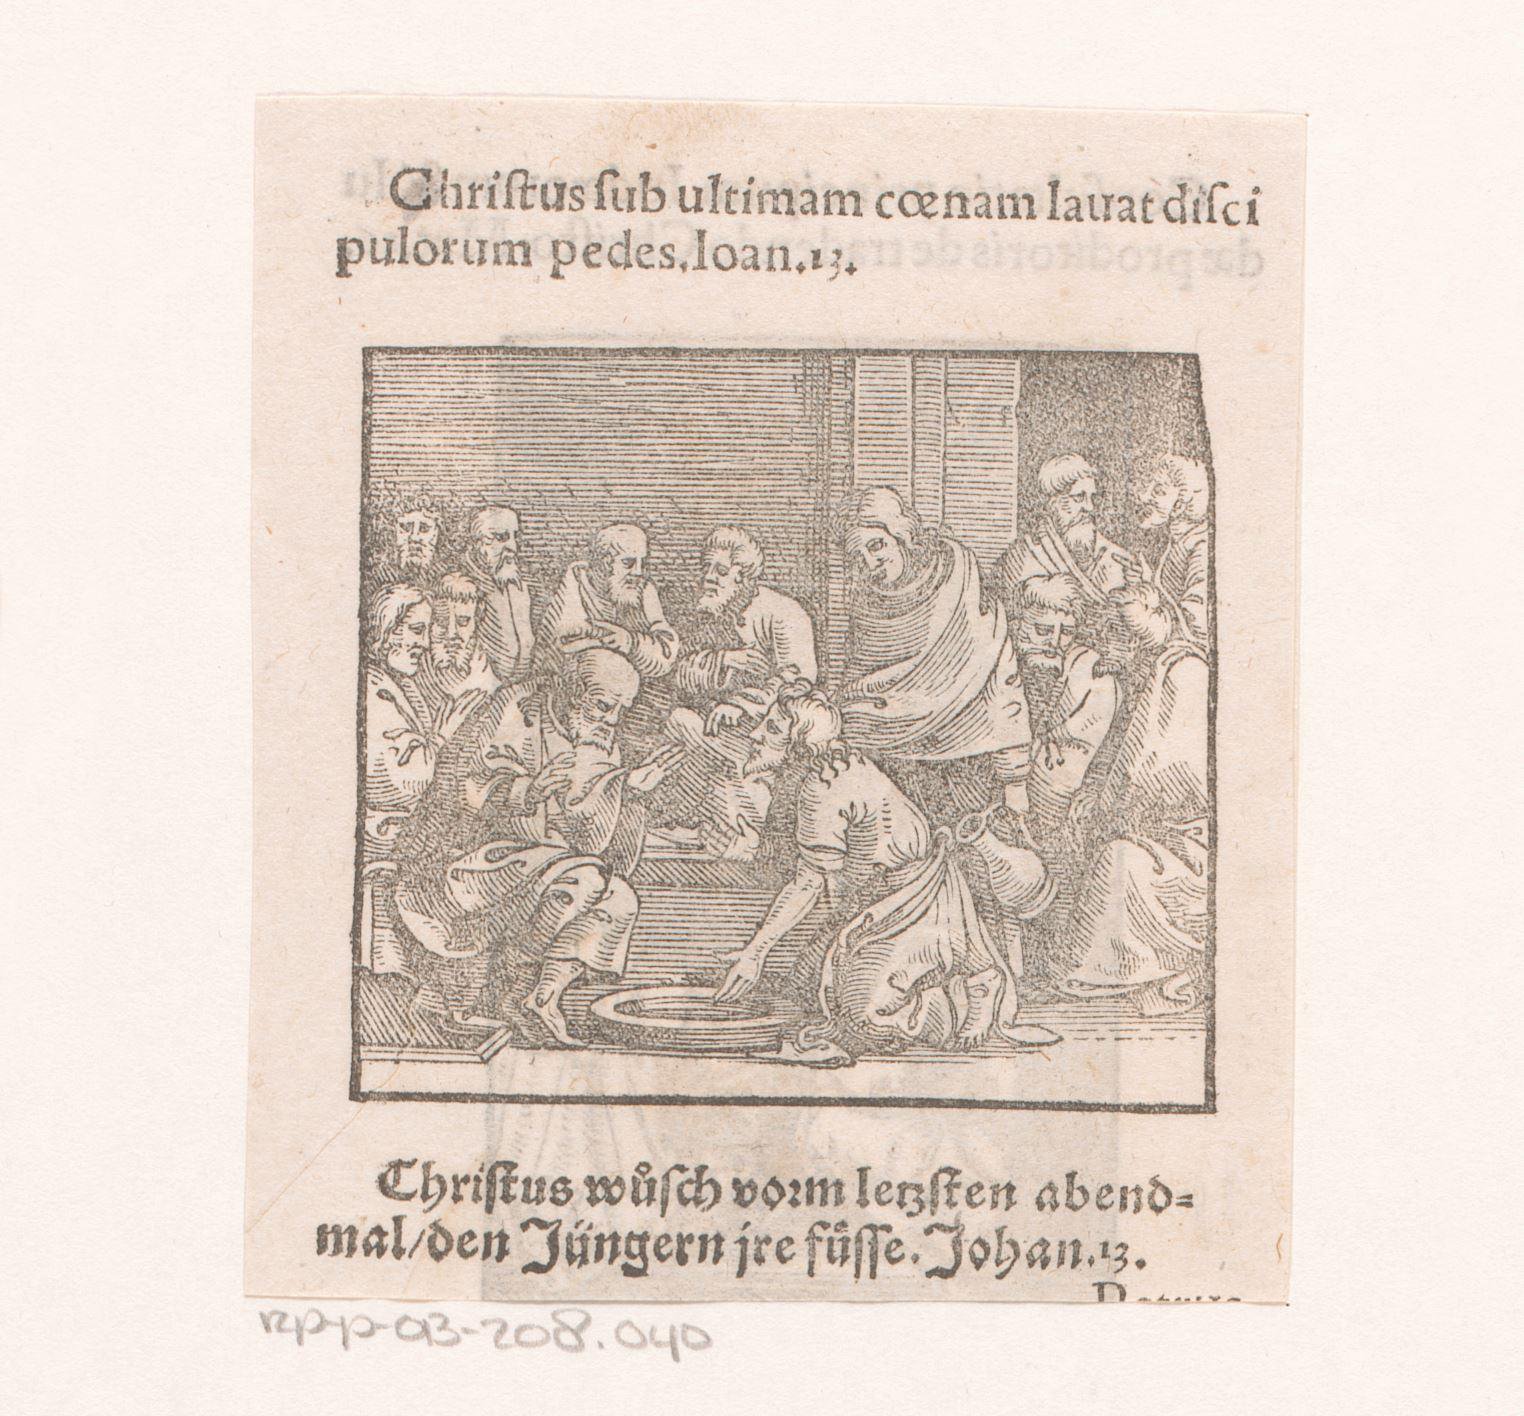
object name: book illustration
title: Christus wast de voeten van de discipelen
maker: Anonymous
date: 1600-1699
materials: paper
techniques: letterpress printing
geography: netherlands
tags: christ washes the feet of the apostles (john 13:1-20)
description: Christus wast de voeten van Petrus. Rondom wachten de andere discipelen om ook hun voeten door Christus te laten wassen.